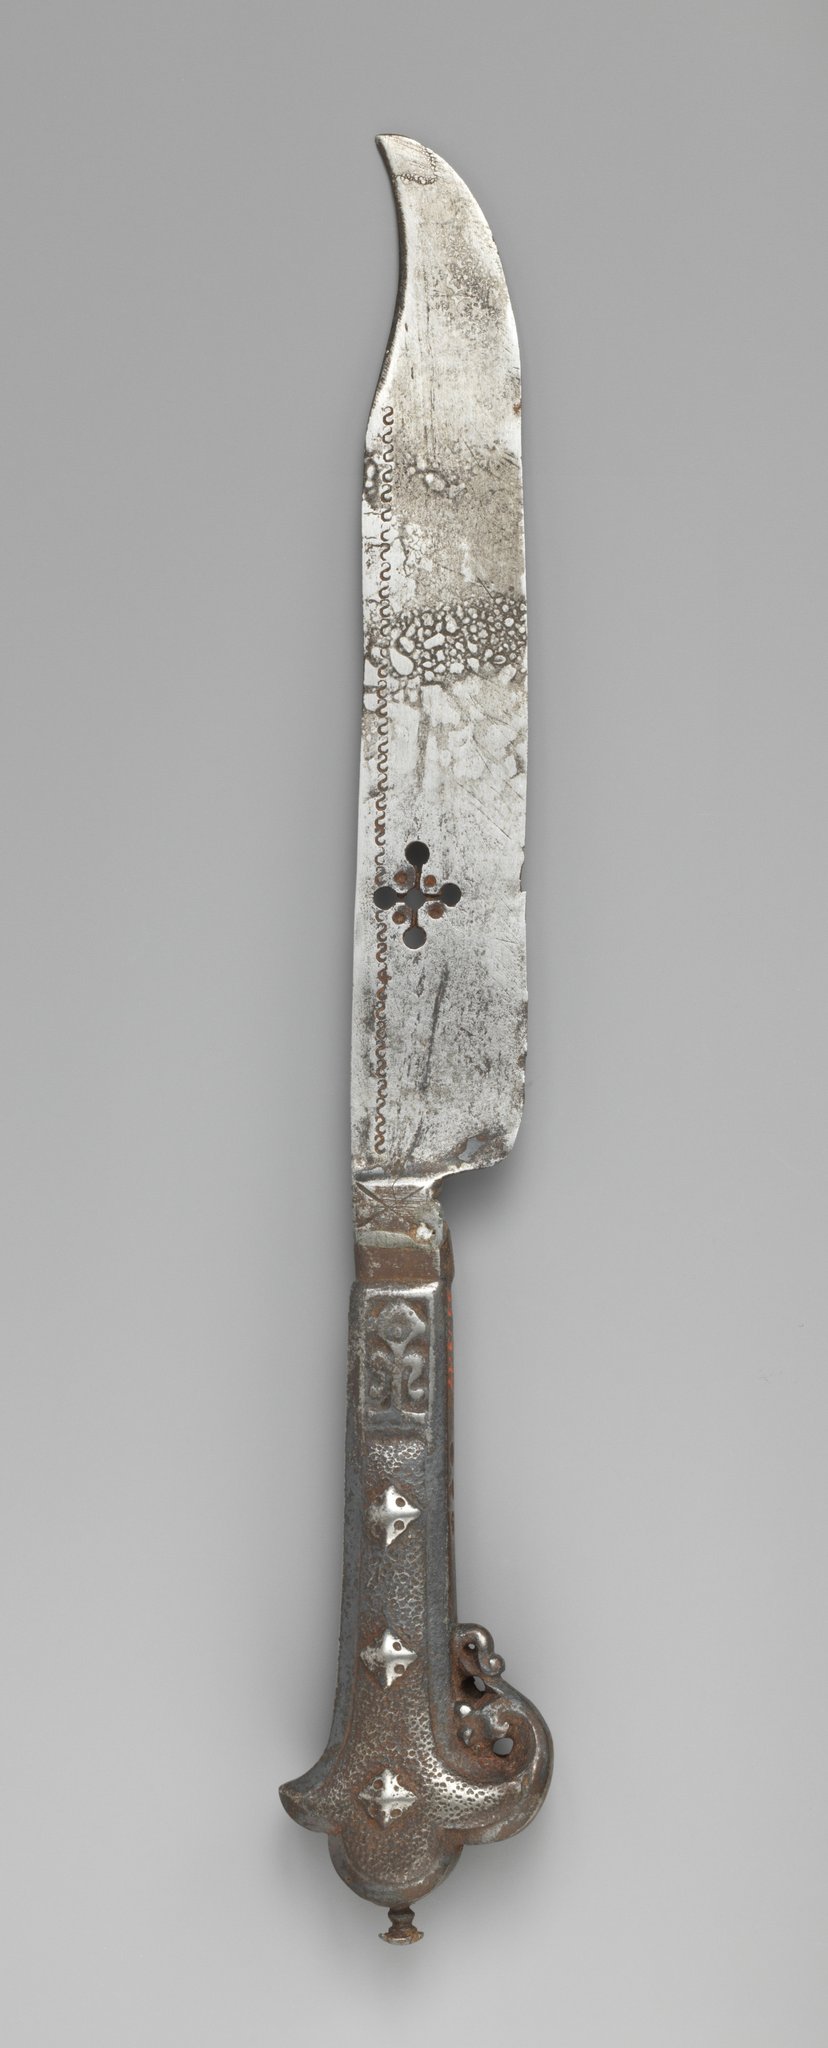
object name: table knife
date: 1801-1900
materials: iron, steel